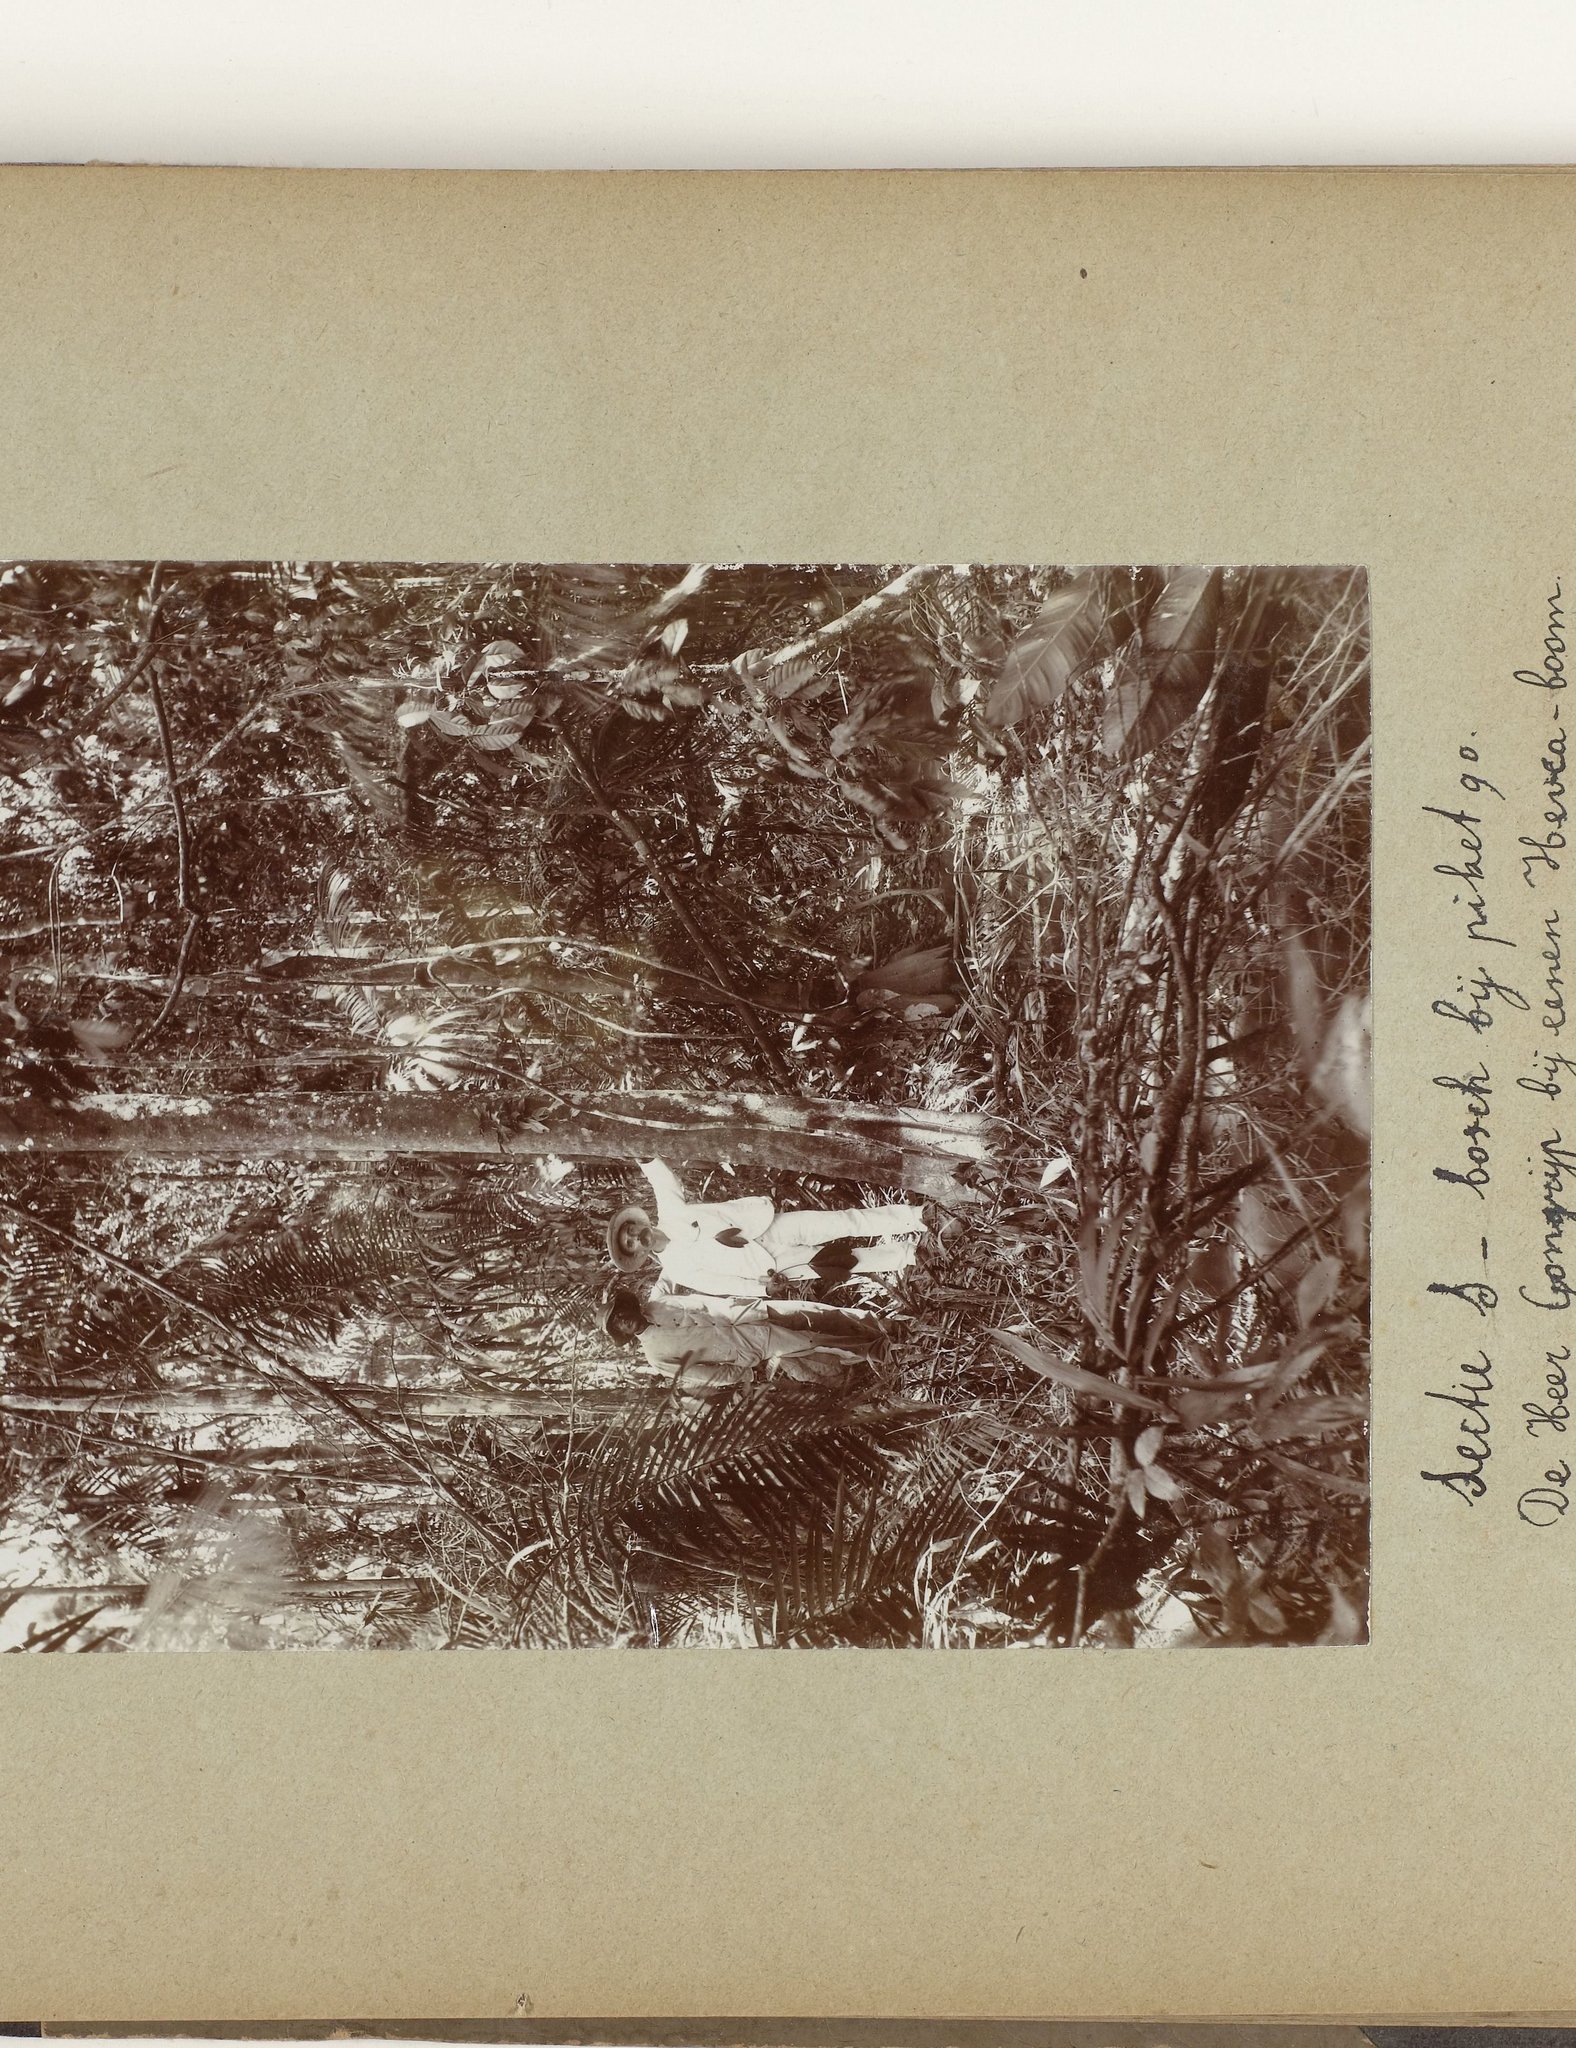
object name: photograph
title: Sectie S - bosch bij piket 90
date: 1905-1910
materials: photographic support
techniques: photography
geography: suriname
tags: jacob evert wesenhagen, railway, tramway; rack railway, suriname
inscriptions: inscription: ‘Sectie S - bosch bij piket 90. De Heer Gongrijp bij eenen Hevea-boom.’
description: De heer Gonggrijp staande in het oerwoud bij een Heveaboom (rubberboom). Foto in het fotoalbum over de aanleg van de Lawaspoorweg in Suriname in de jaren 1903-1912. Onderdeel van een groep objecten afkomstig van de familie Wesenhagen in Suriname.